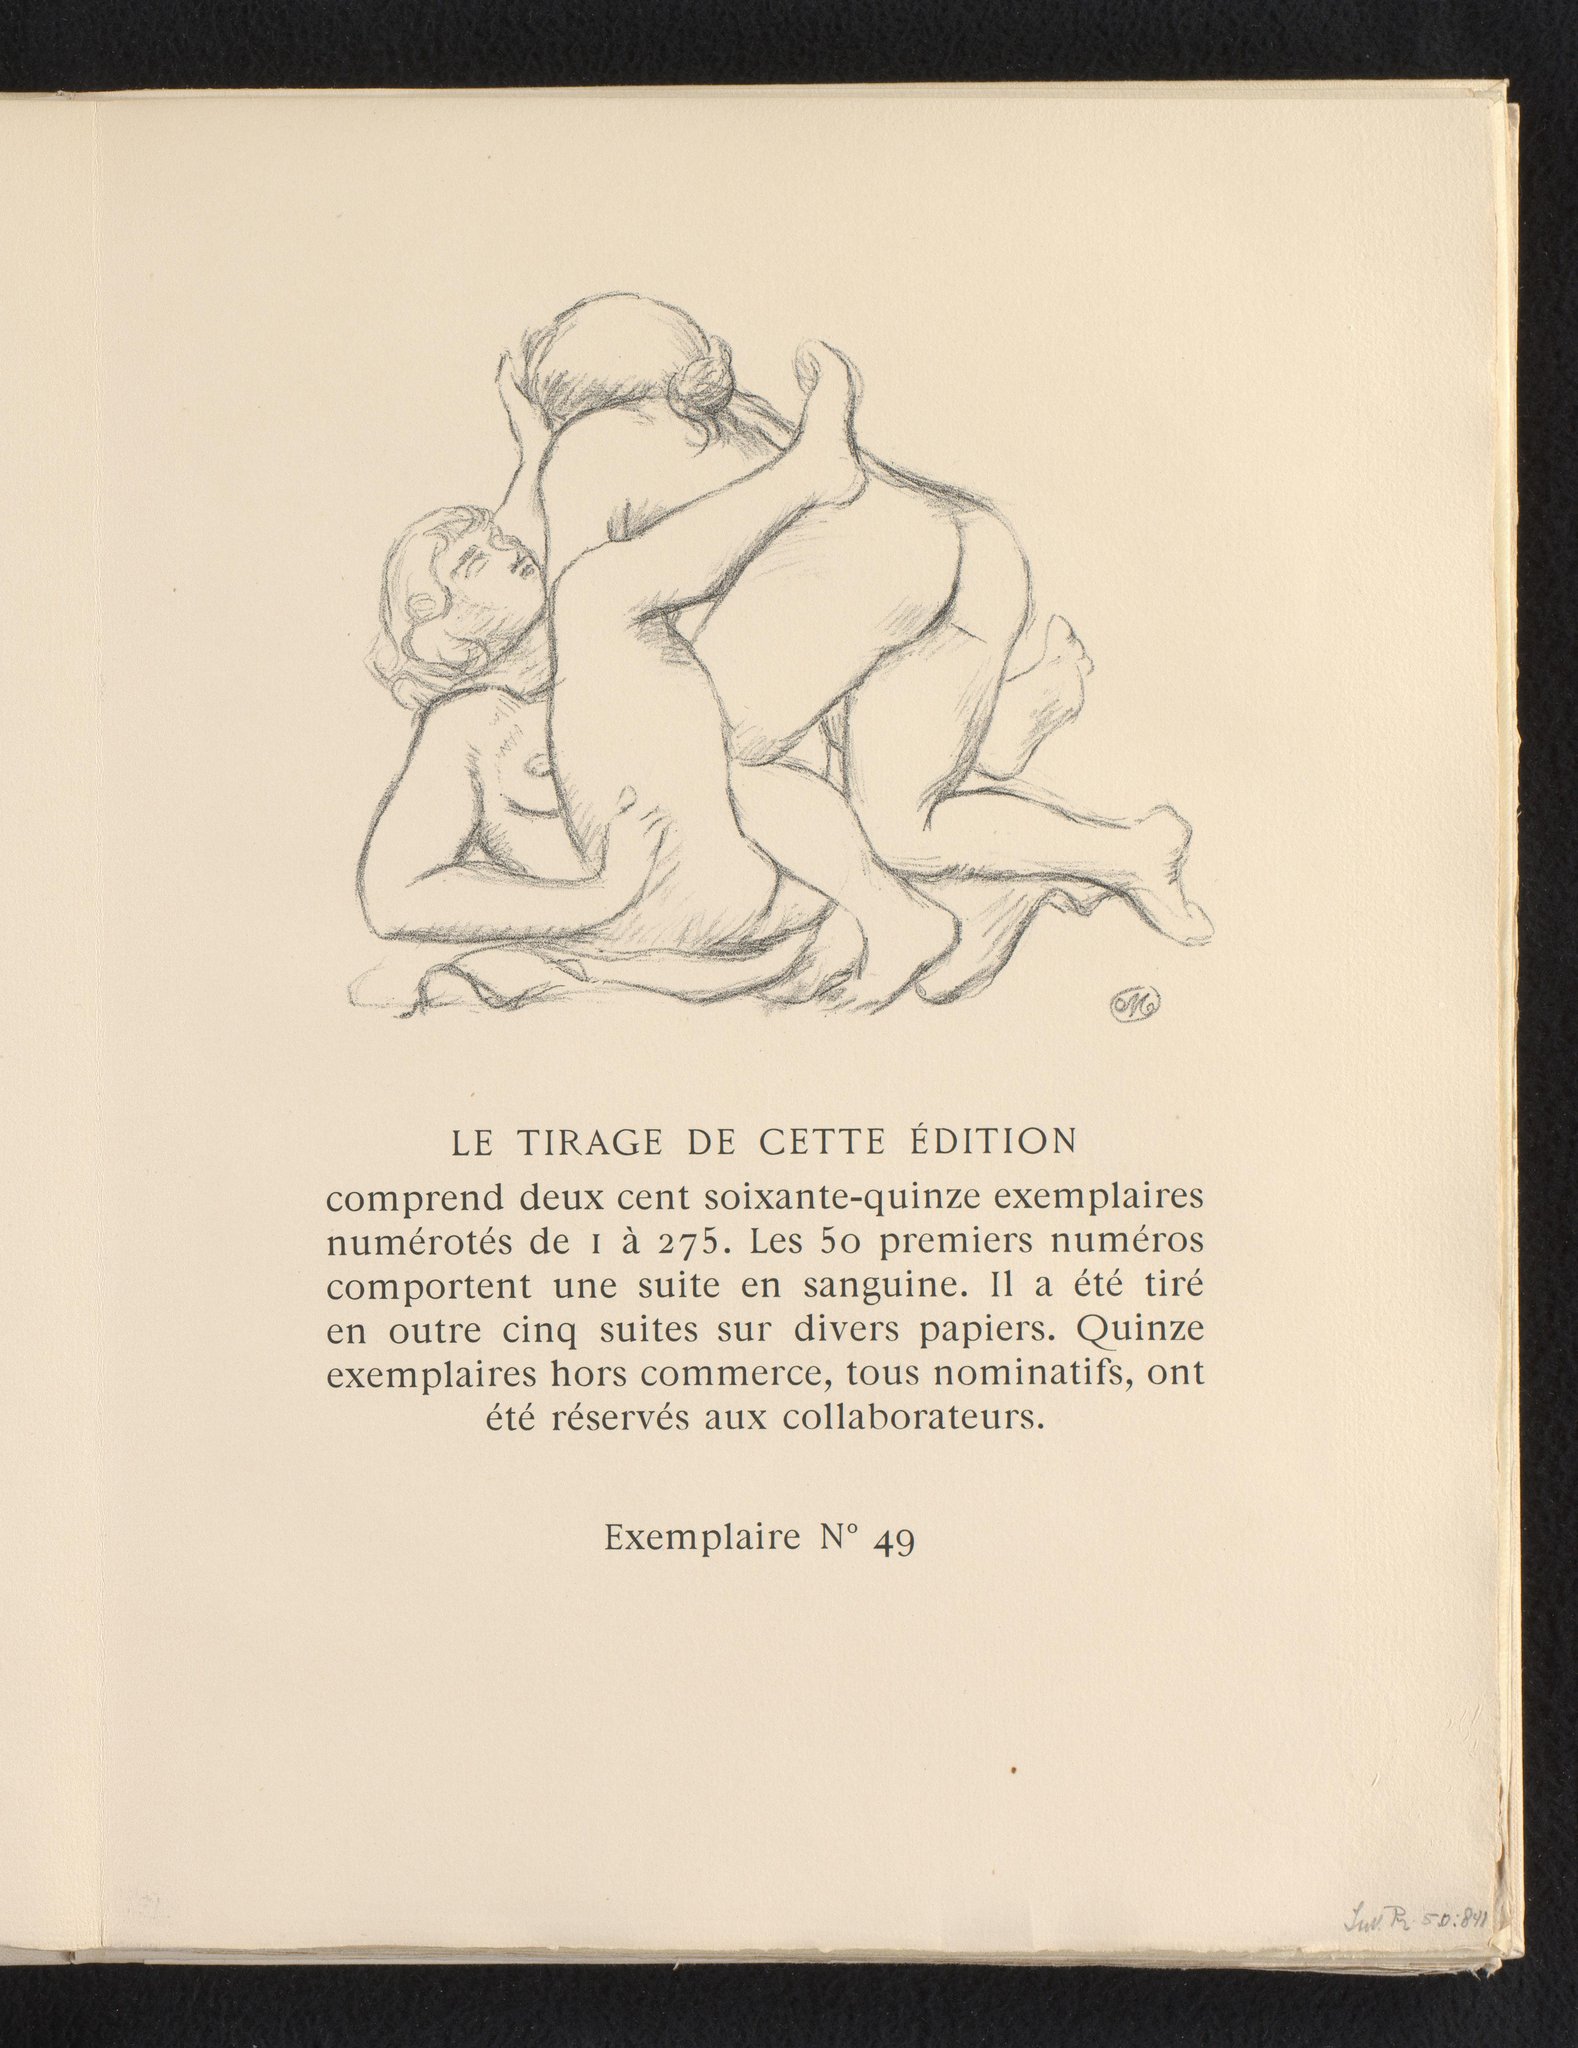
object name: book illustration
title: Vrijend paar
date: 1948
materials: paper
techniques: letterpress printing, lithograph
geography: paris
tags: (showing oneself) undressed, quasi-nude, couple of lovers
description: Prent uit: Lucianus van Samosata. Dialogues des Courtisanes. [Vertaald uit het Grieks door] Charles Astruc. Parijs: s.n., 1948, boven colofon.